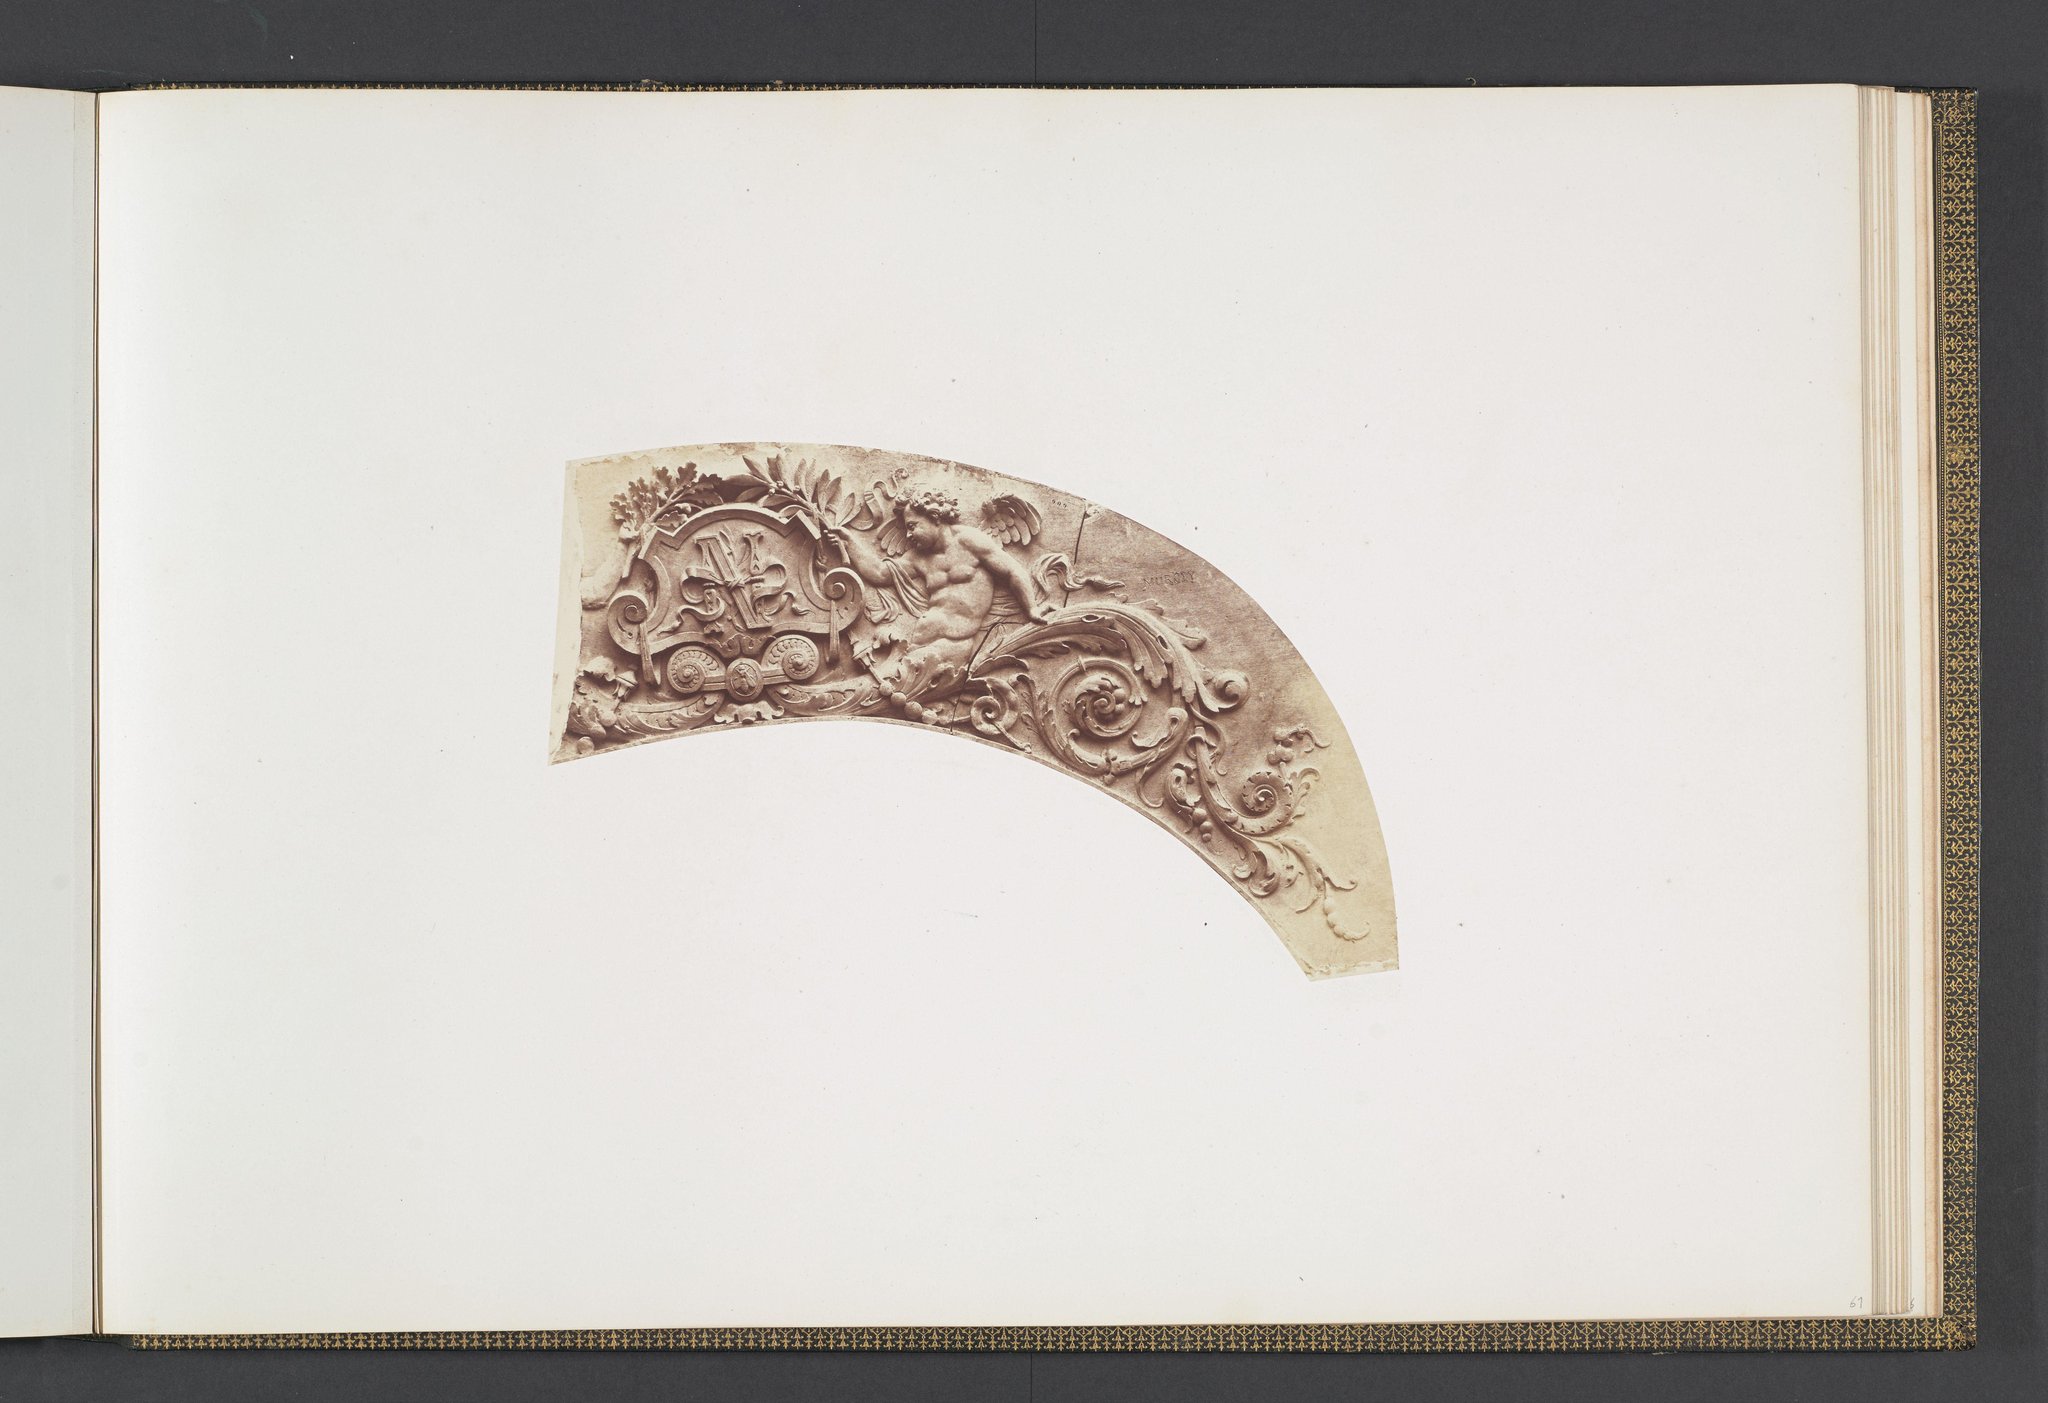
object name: album leaf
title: Gipsmodel voor een gewelfversiering van het Palais du Louvre door François Théophile Murgey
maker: édouard denis baldus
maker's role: fotograaf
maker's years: 1813-1889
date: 1855-1857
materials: paper, photographic support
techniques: salted paper print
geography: paris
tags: permanent exhibition, museum, ornamenting, decorating ~ applied arts, paris, tuileries palace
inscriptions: number: ‘909’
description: Onderdeel van Réunion des Tuileries au Louvre 1852-1857, album 3.